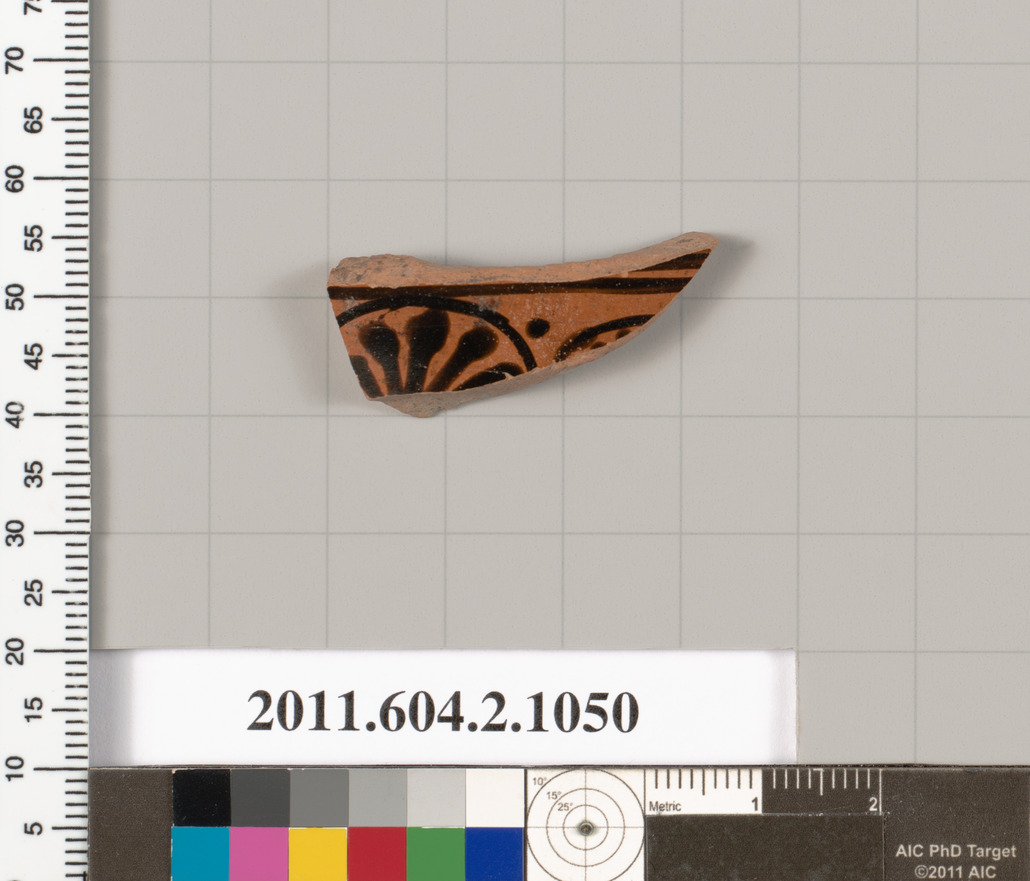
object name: pelike fragment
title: Terracotta fragment of a pelike (jar)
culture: greek, attic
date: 500-476 BCE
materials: terracotta